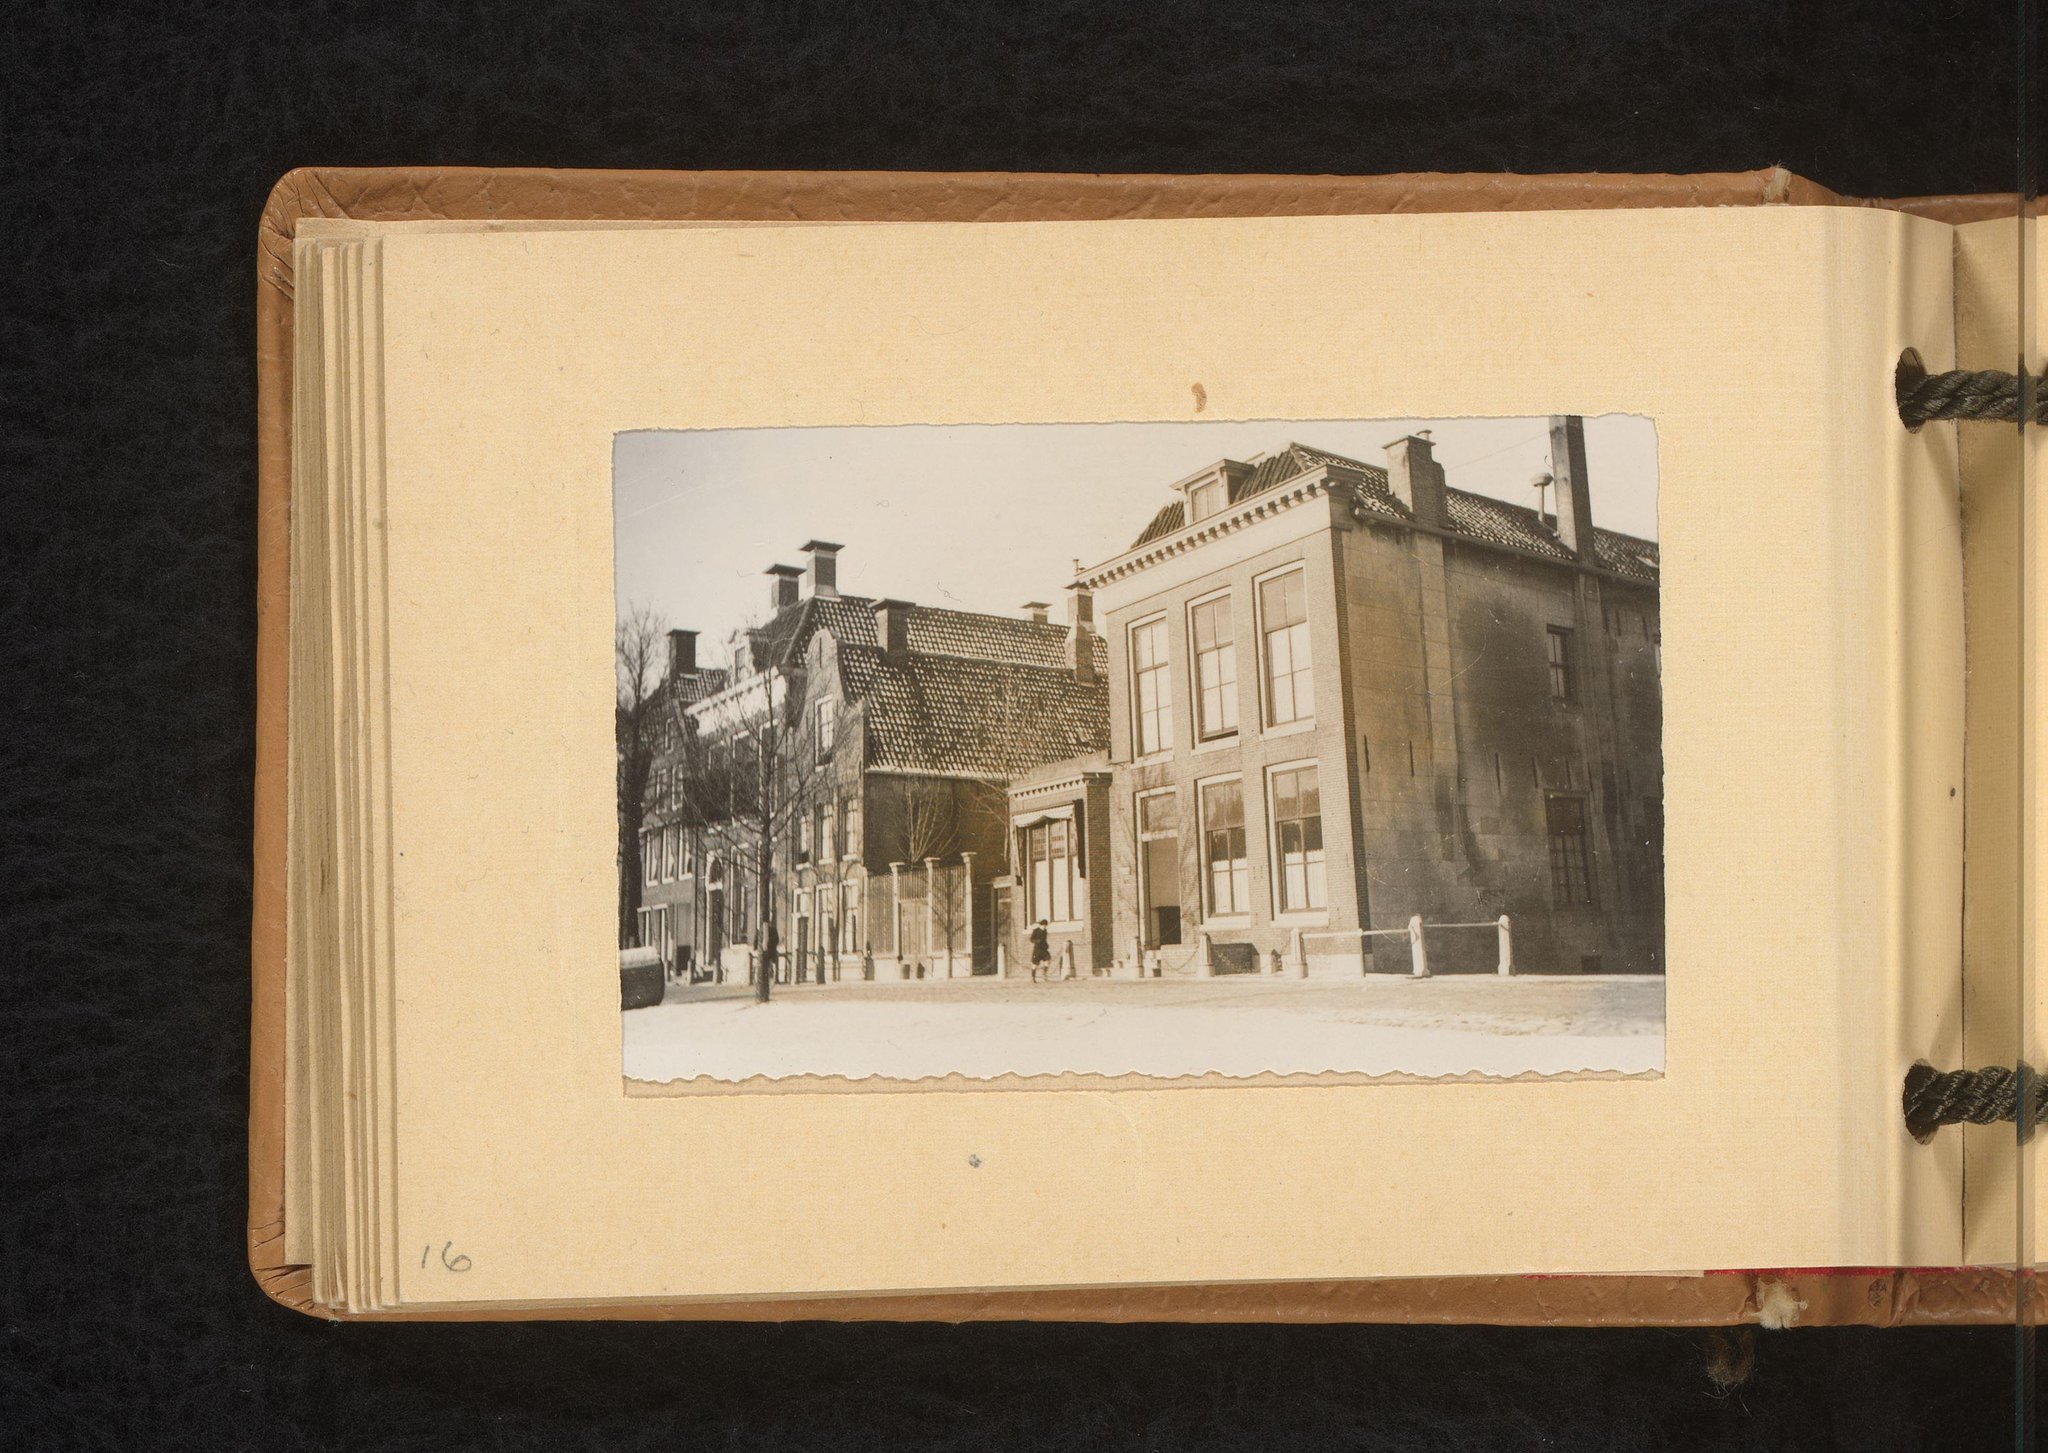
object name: photograph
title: Gebouw van de Kriegsmarine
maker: Anonymous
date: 1940-1943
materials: paper, photographic support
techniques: gelatin silver print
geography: netherlands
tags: shelter ~ military service, occupation ~ war, public road (+ city(-scape) with figures, staffage), netherlands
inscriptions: name: ‘Fotob. Zegel 255’, inscription: ‘Unsere Haus ...’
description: Albumblad met een foto van een rij huizen in een Nederlandse stad met rechts het gebouw van de Kriegsmarie (Dienststelle 23 443). Onderdeel van een klein album van de Kriegsmarine in Nederland.